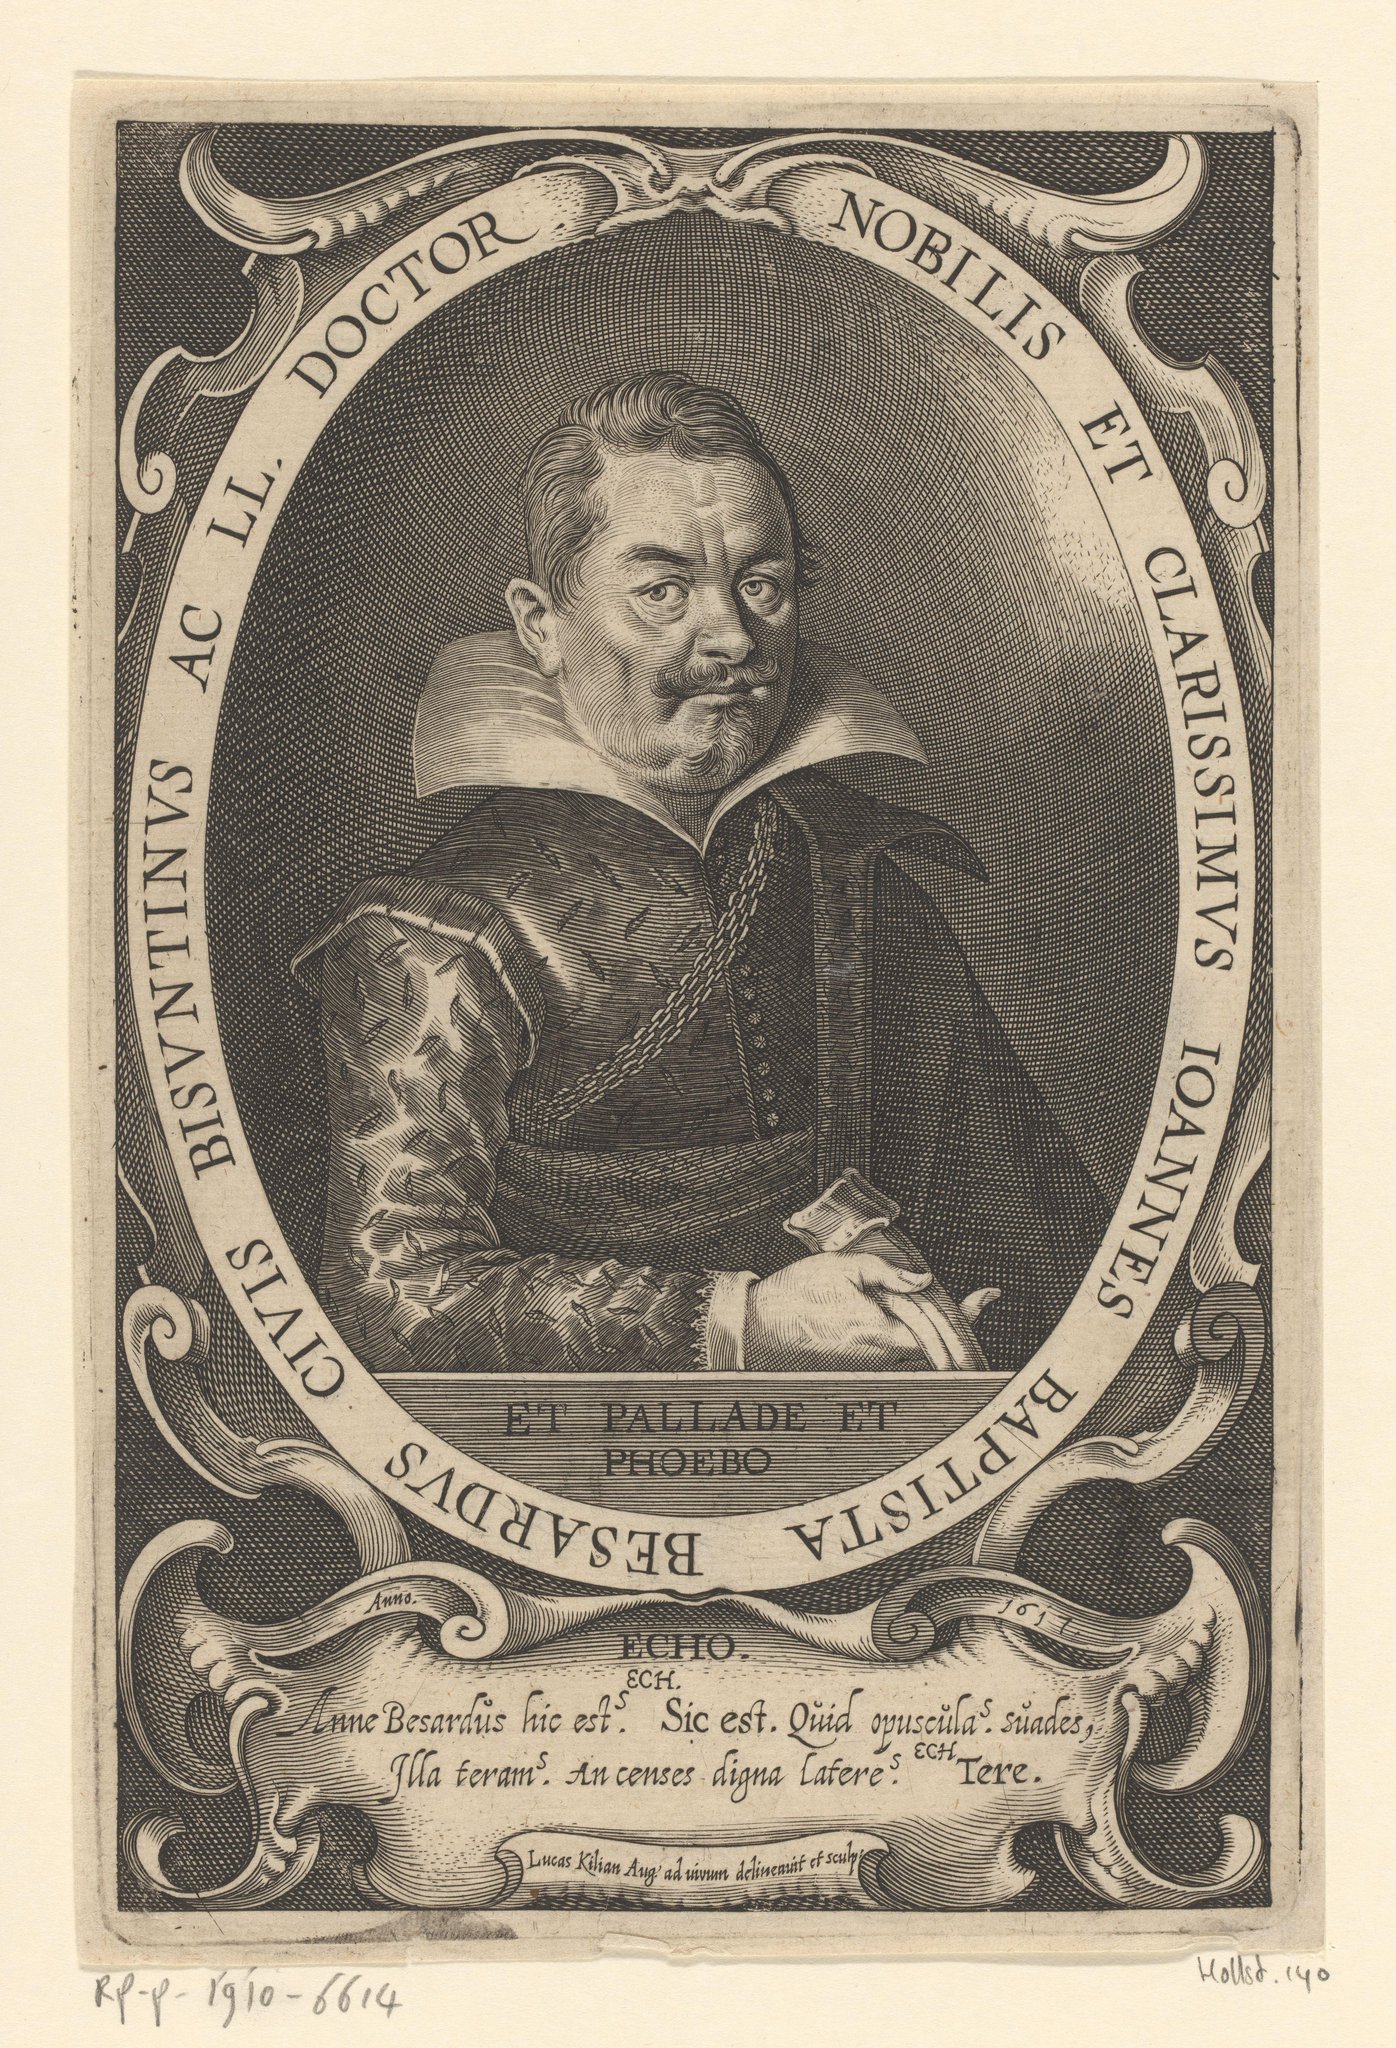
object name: print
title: Portret van Jean-Baptiste Besard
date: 1617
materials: paper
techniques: engraving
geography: augsburg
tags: augsburg, musician, historical persons, portrait of composer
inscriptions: collector's mark: Lugt 2228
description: Tekst in het Latijn in de omlijsting en in de cartouche.